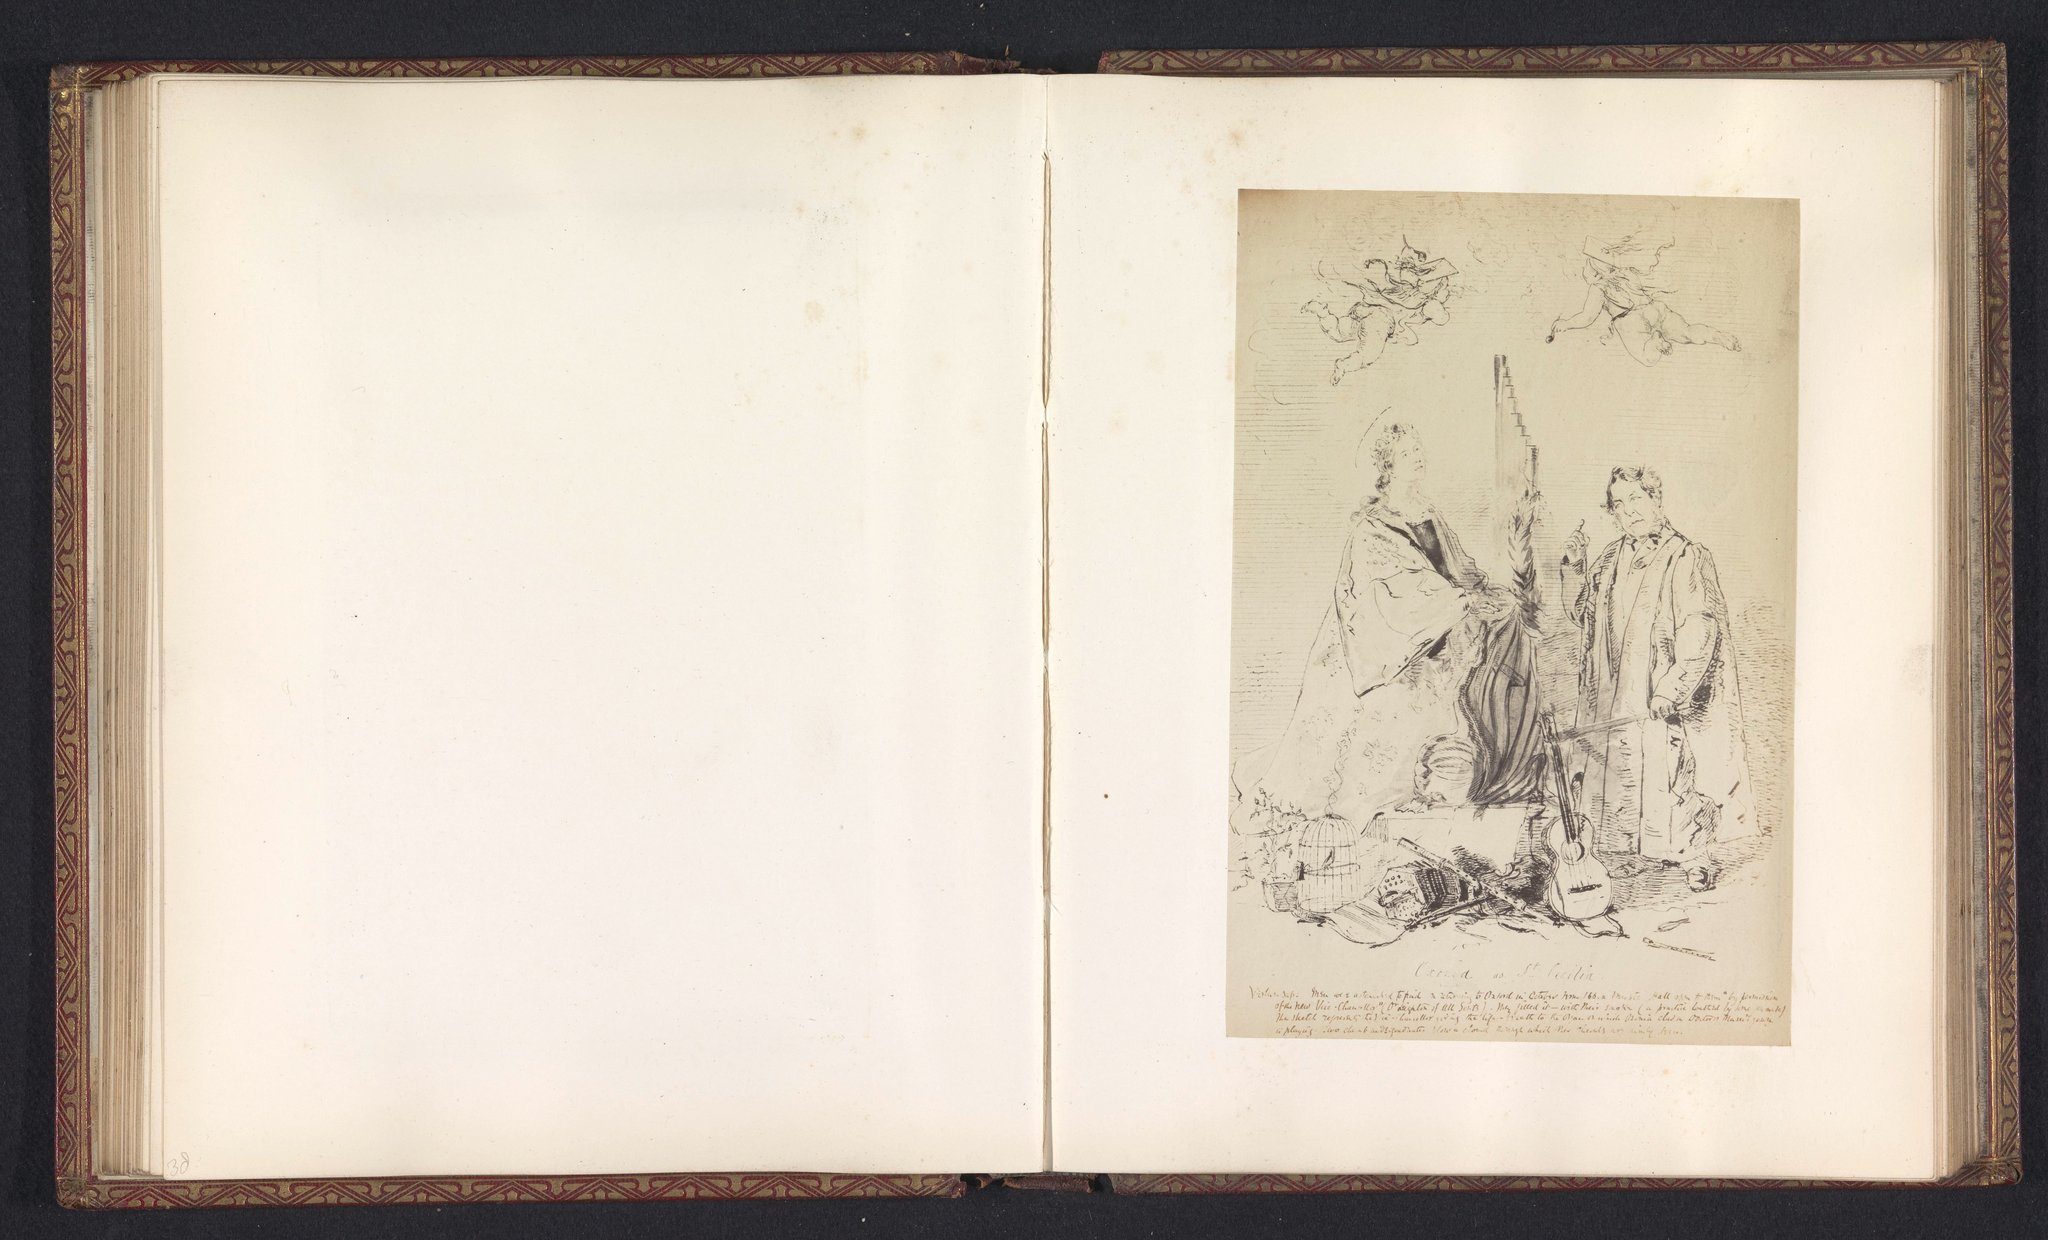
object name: photograph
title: Fotoreproductie van een tekening, voorstellende Oxford als de heilige Cecilia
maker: Anonymous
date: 1855-1866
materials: photographic support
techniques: albumen print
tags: the virgin martyr cecilia of rome; possible attributes: falcon, musical instruments, organ, wreath of roses and lilies, personification of a city, town-patron(ess), caricatures (human types), student life